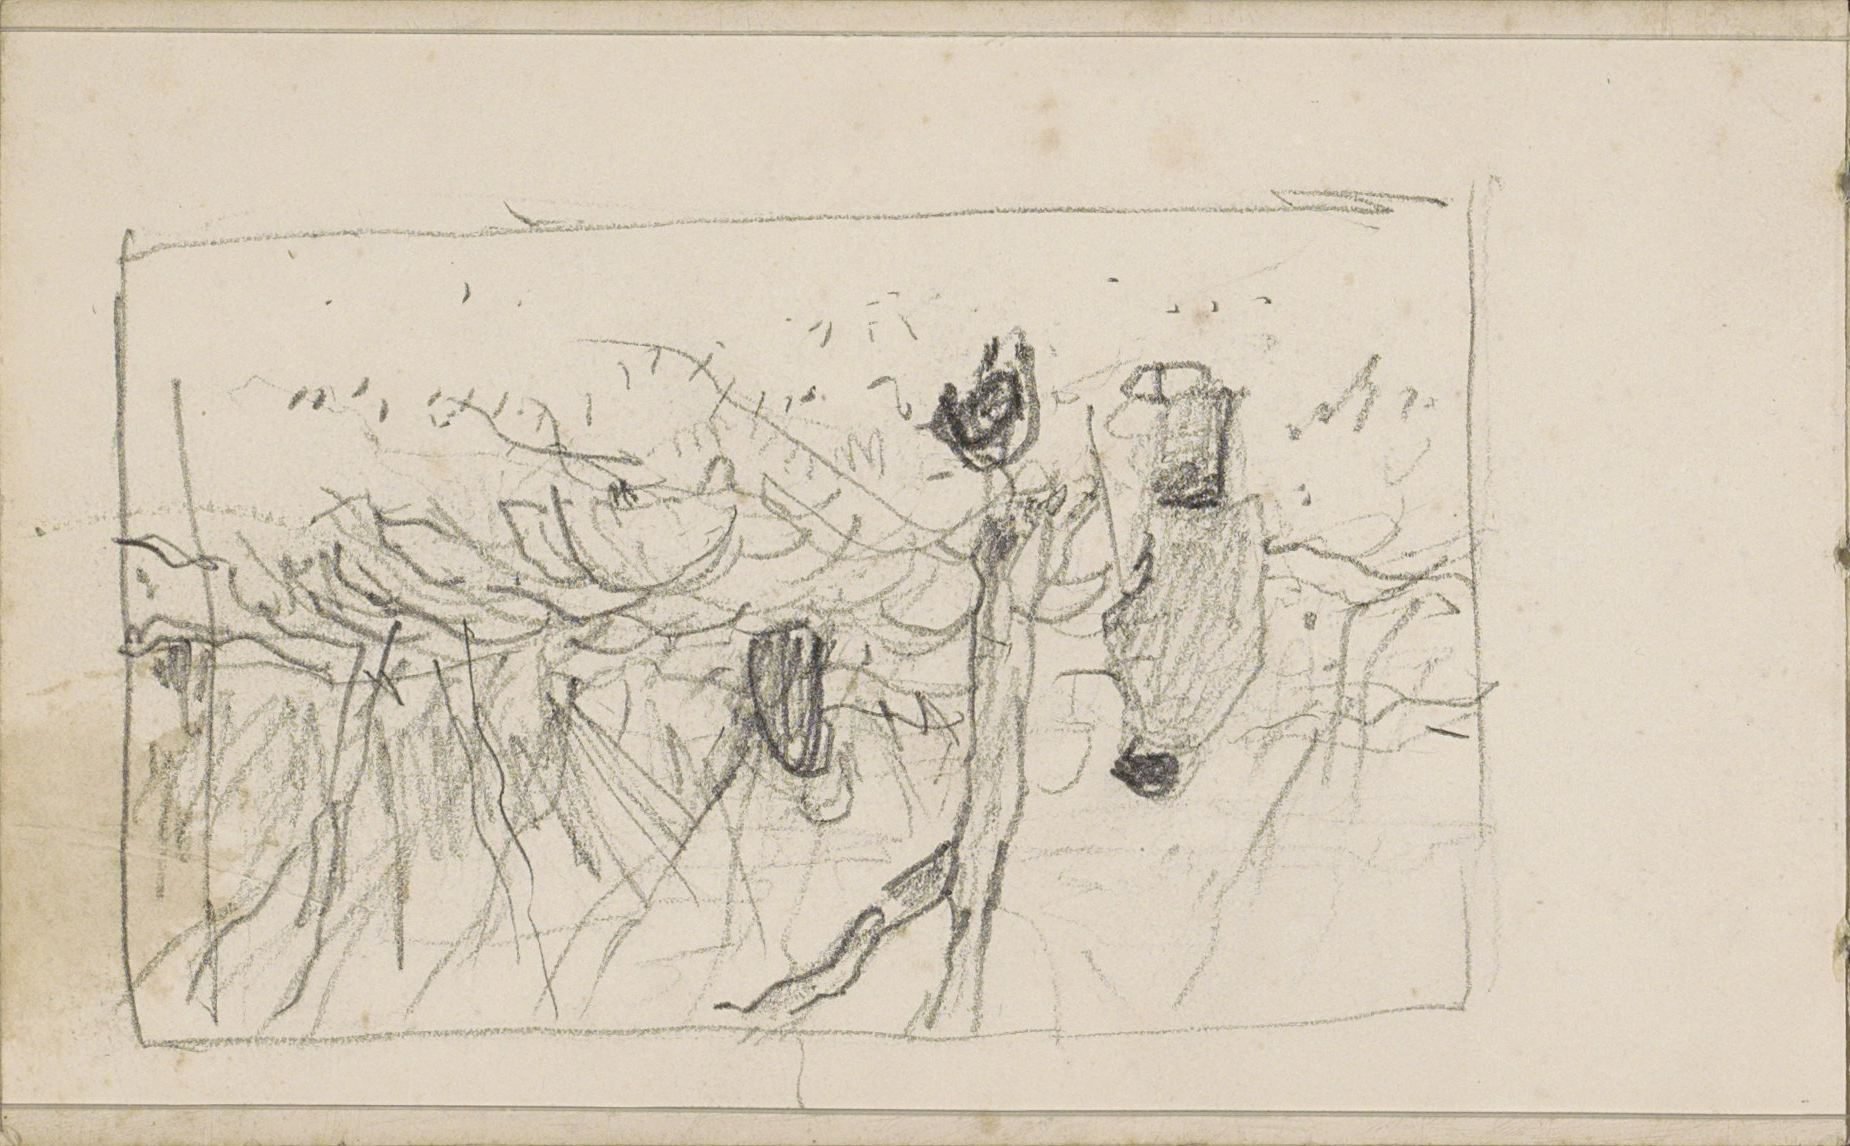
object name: sketchbook leaf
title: Herder met een hond en kudde schapen bij een boom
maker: anton mauve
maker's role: draughtsman, painter, print maker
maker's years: 1838-1888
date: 1876-1888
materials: paper, pencil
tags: herding, herdsman, herdswoman, shepherd, shepherdess, cowherd, etc., sheep, herd, flock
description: Blad 33 verso uit een schetsboek met 34 bladen.